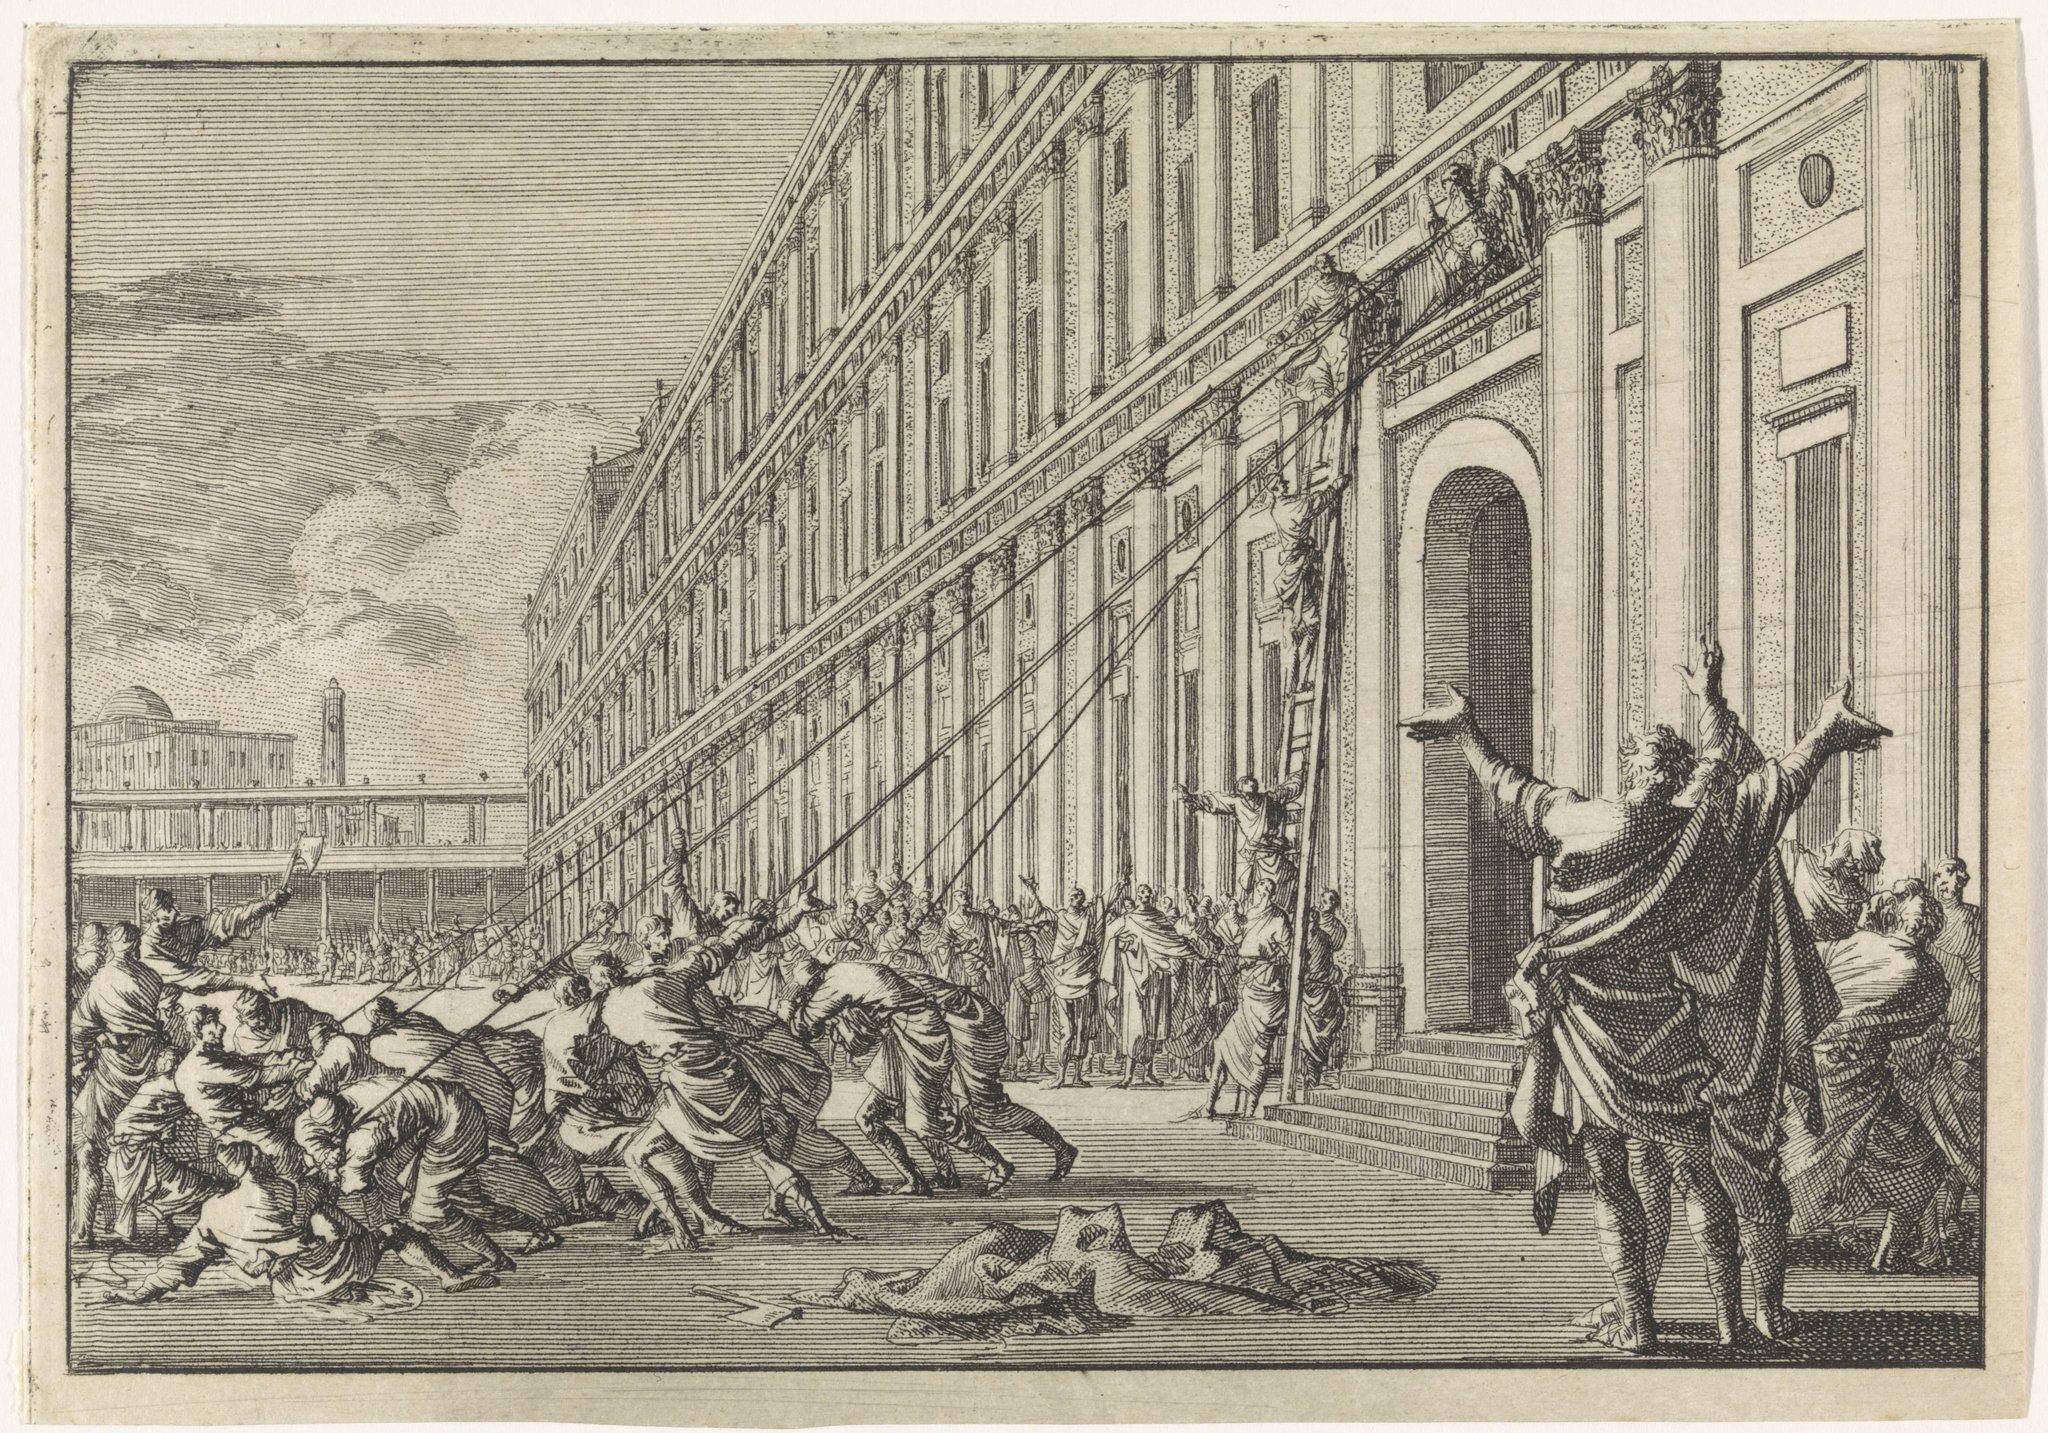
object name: print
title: De gouden arend van Herodes wordt door het volk met touwen van de tempel gerukt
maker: jan luyken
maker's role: draughtsman, print maker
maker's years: 1649-1712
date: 1704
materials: paper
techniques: etching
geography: amsterdam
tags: damaging or destroying a work of art, monument, statue, the temple (in general) ~ jewish religion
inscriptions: collector's mark: Lugt 2228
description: Prent ook gebruikt als boekillustratie in: Josephus, Flavius. Alle de Werken, 2 delen. Amsterdam: Pieter Mortier, 1704, dl. 2, p. 557.